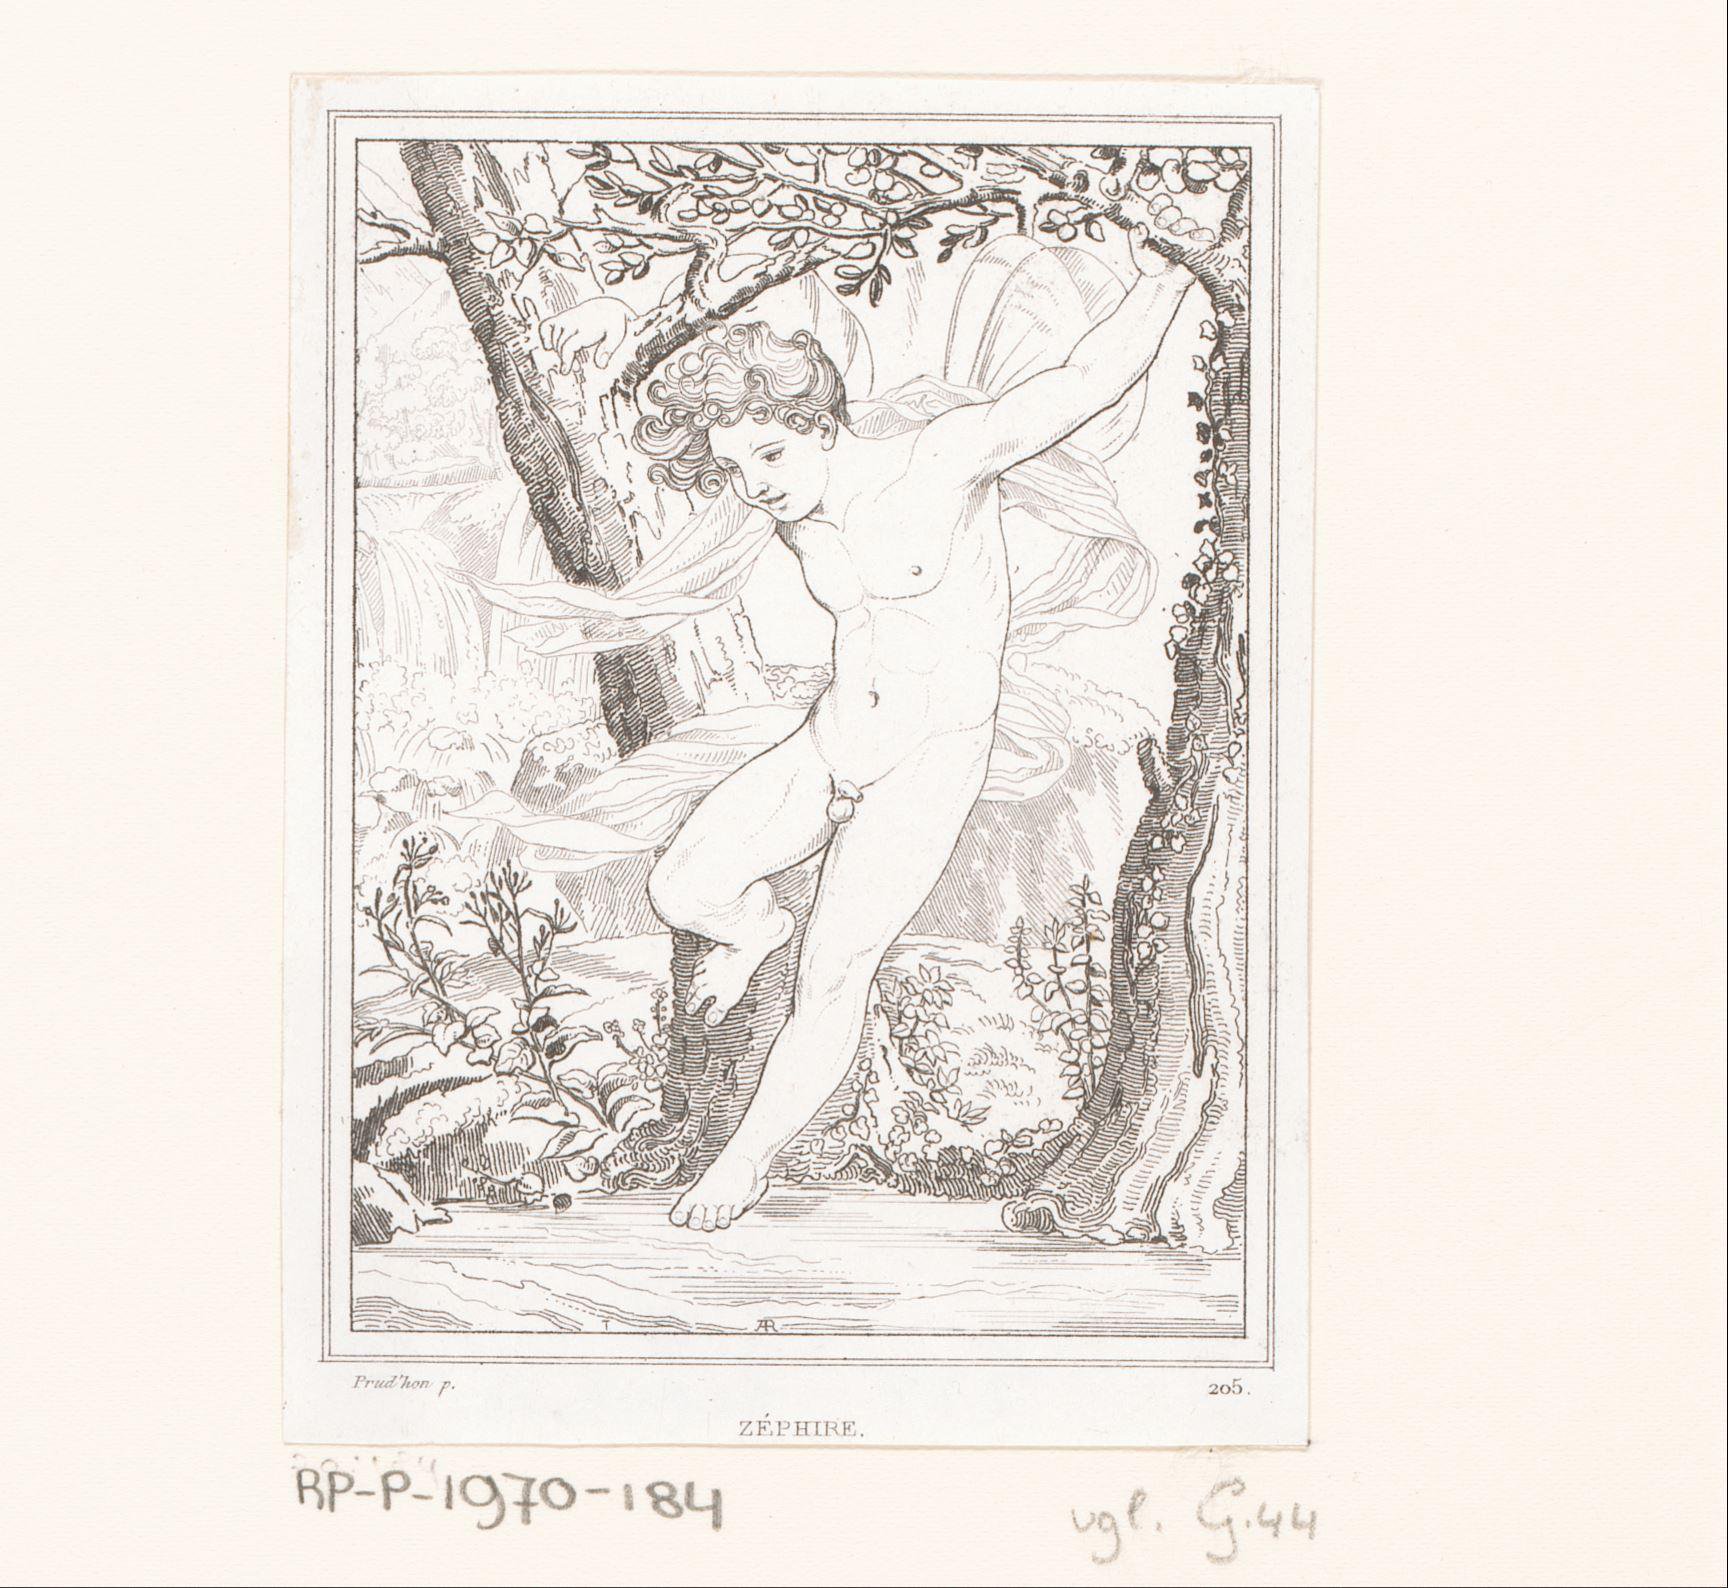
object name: print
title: Zephyrus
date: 1810-1851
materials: paper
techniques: etching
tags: (story of) zephyrus (favonius), the west wind; 'favonio o zeffiro' (ripa)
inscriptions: collector's mark: Lugt 2760, collector's mark: Lugt 2228a